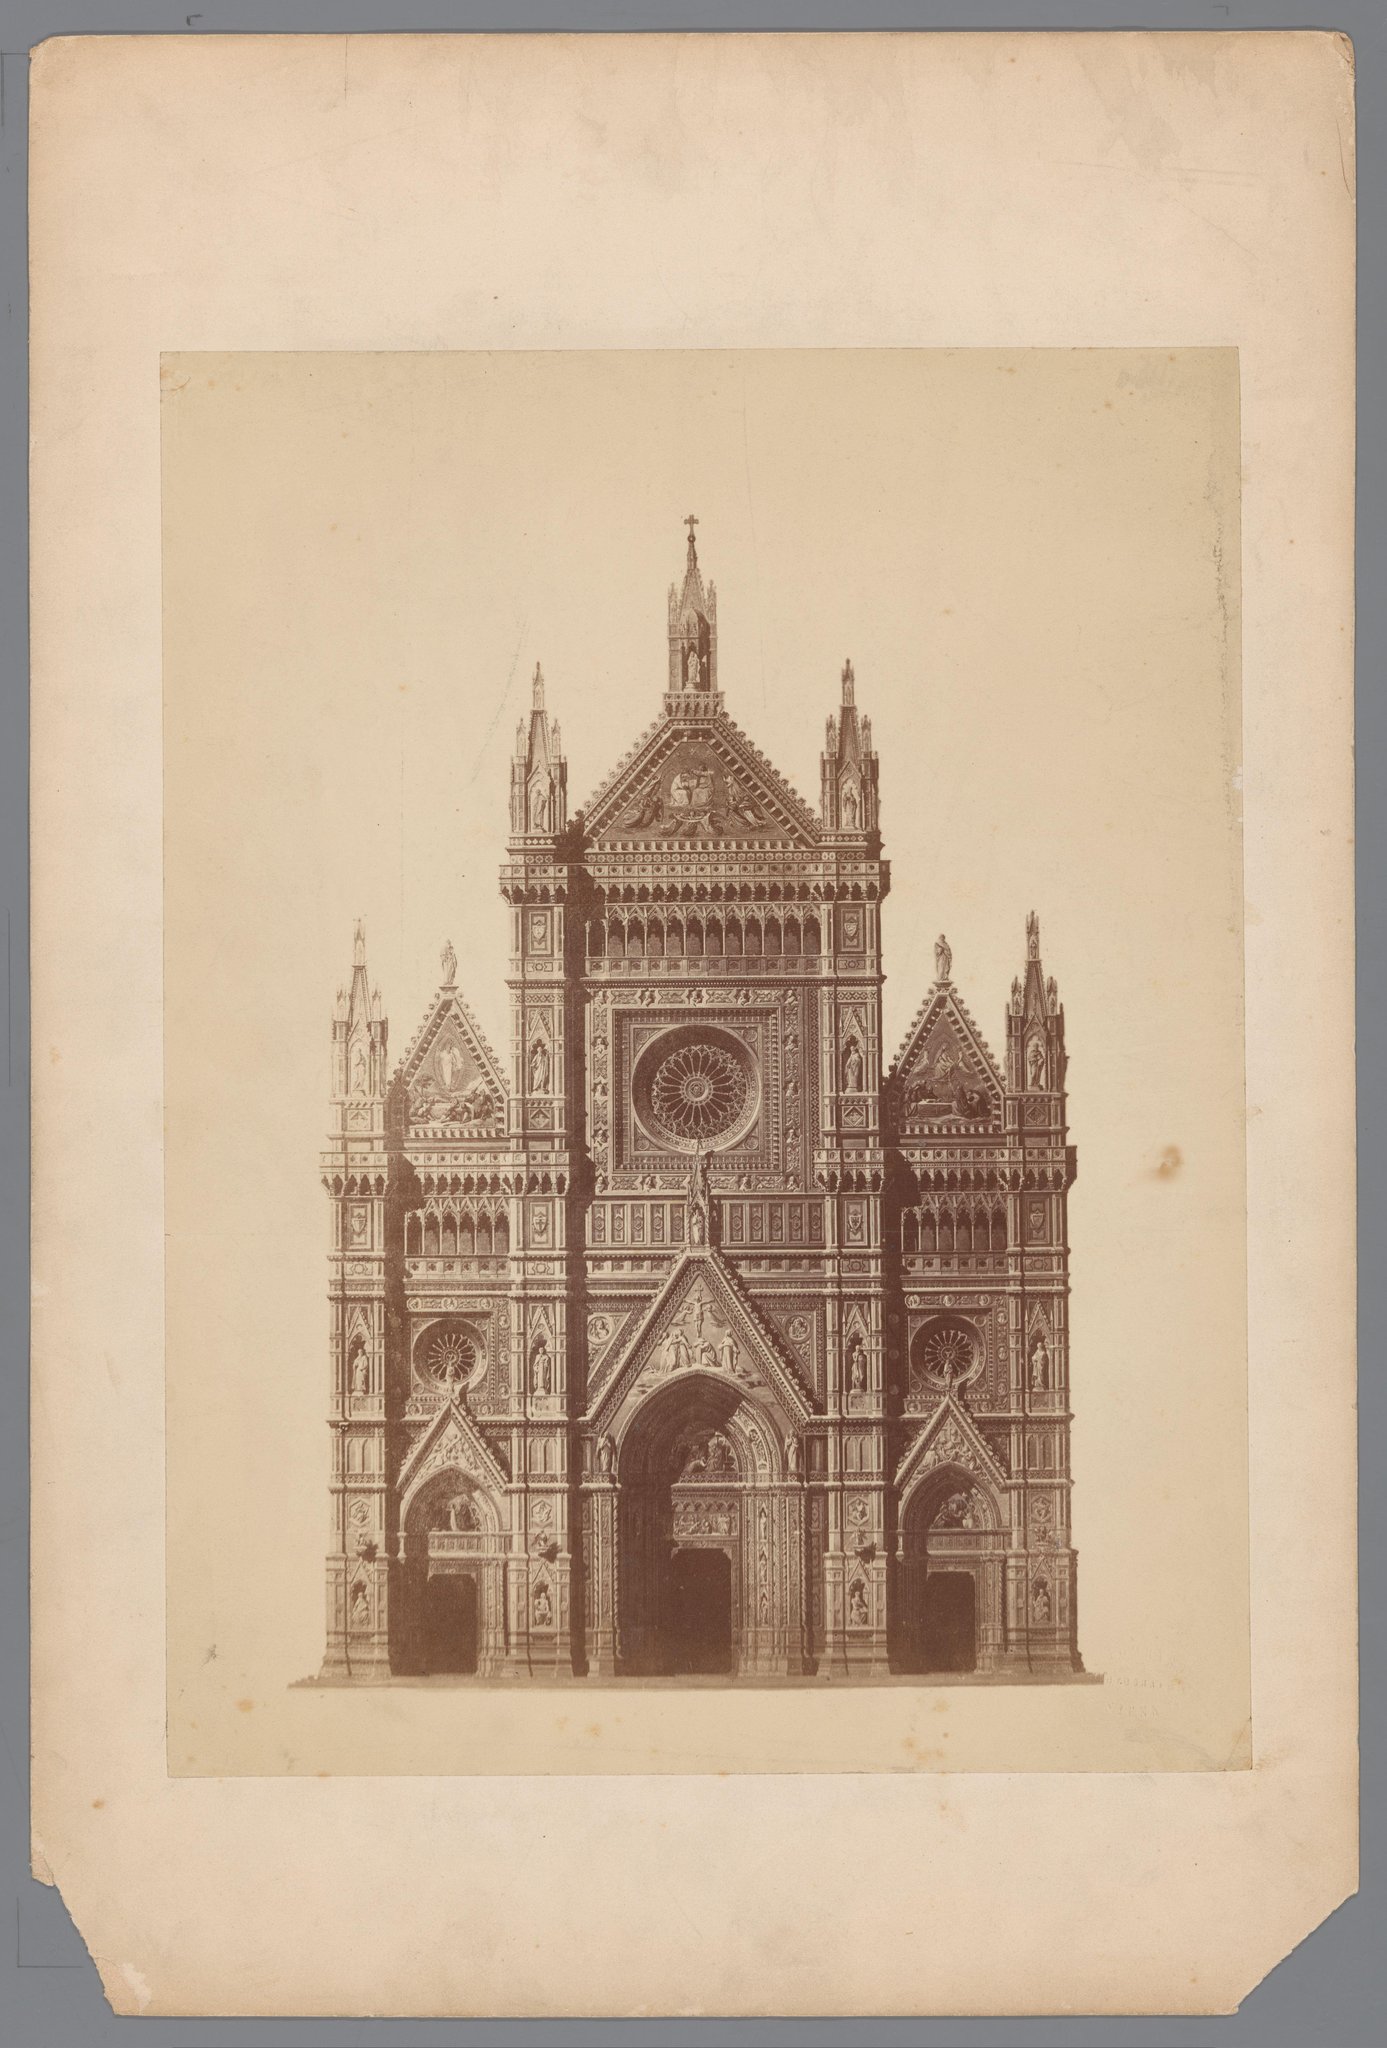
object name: photograph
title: Fotoreproductie van vermoedelijk een prent van een kerkfaçade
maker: paolo lombardi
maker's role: fotograaf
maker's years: 1827-1890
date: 1875-1900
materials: cardboard, photographic support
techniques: albumen print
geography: europe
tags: church (exterior), façade (of house or building), europe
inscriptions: collector's mark: Lugt 3937